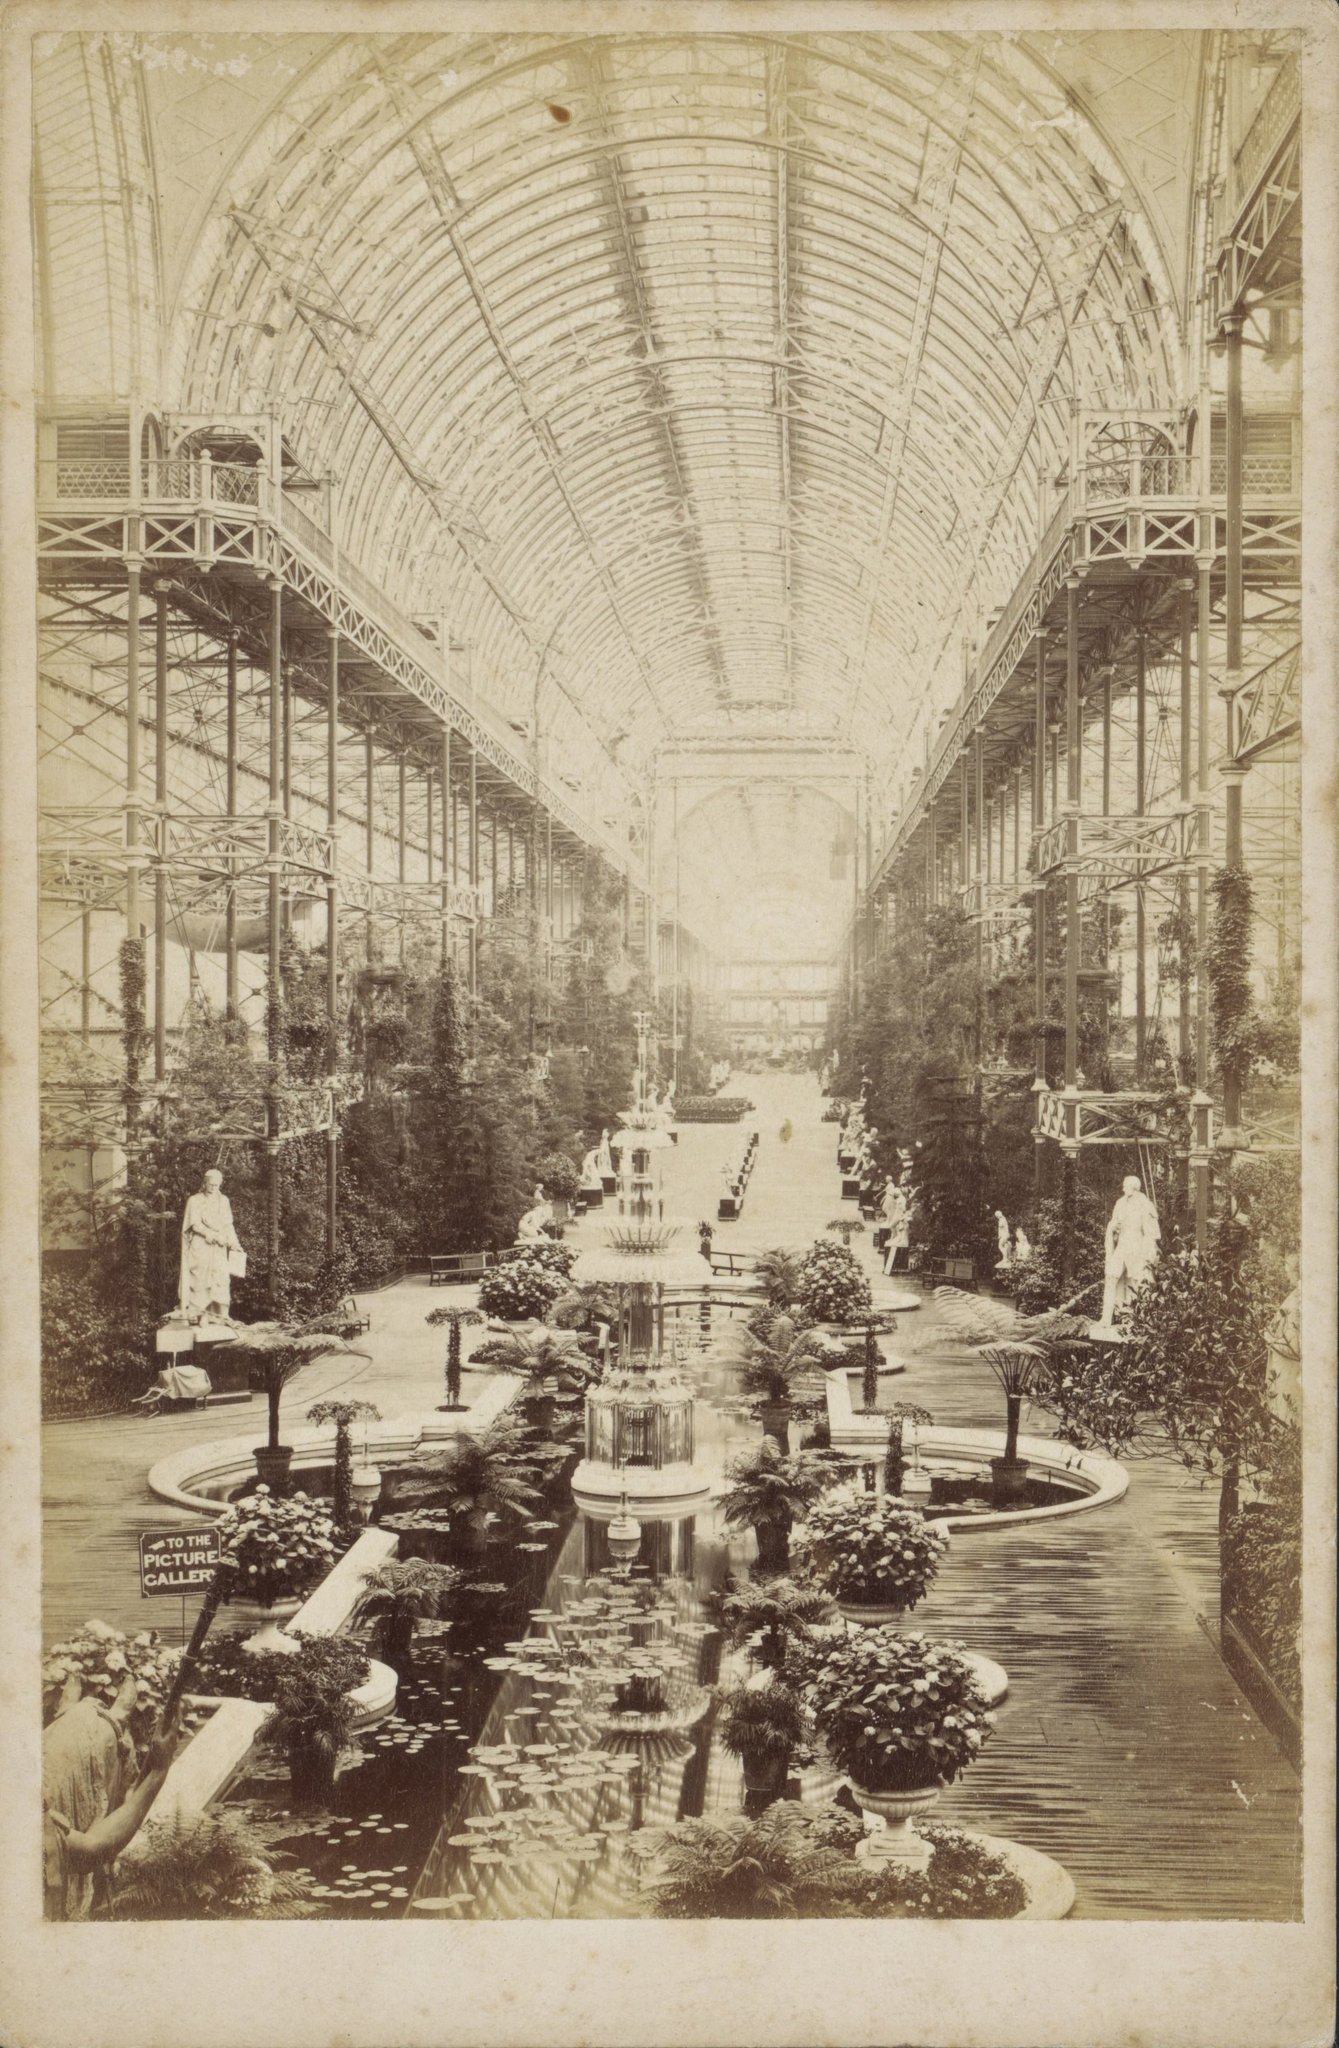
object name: cabinet photograph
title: Interieur van Crystal Palace in Londen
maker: Anonymous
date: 1878-1890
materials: cardboard, paper, photographic support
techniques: albumen print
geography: london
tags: garden fountain, interior ~ representation of a building